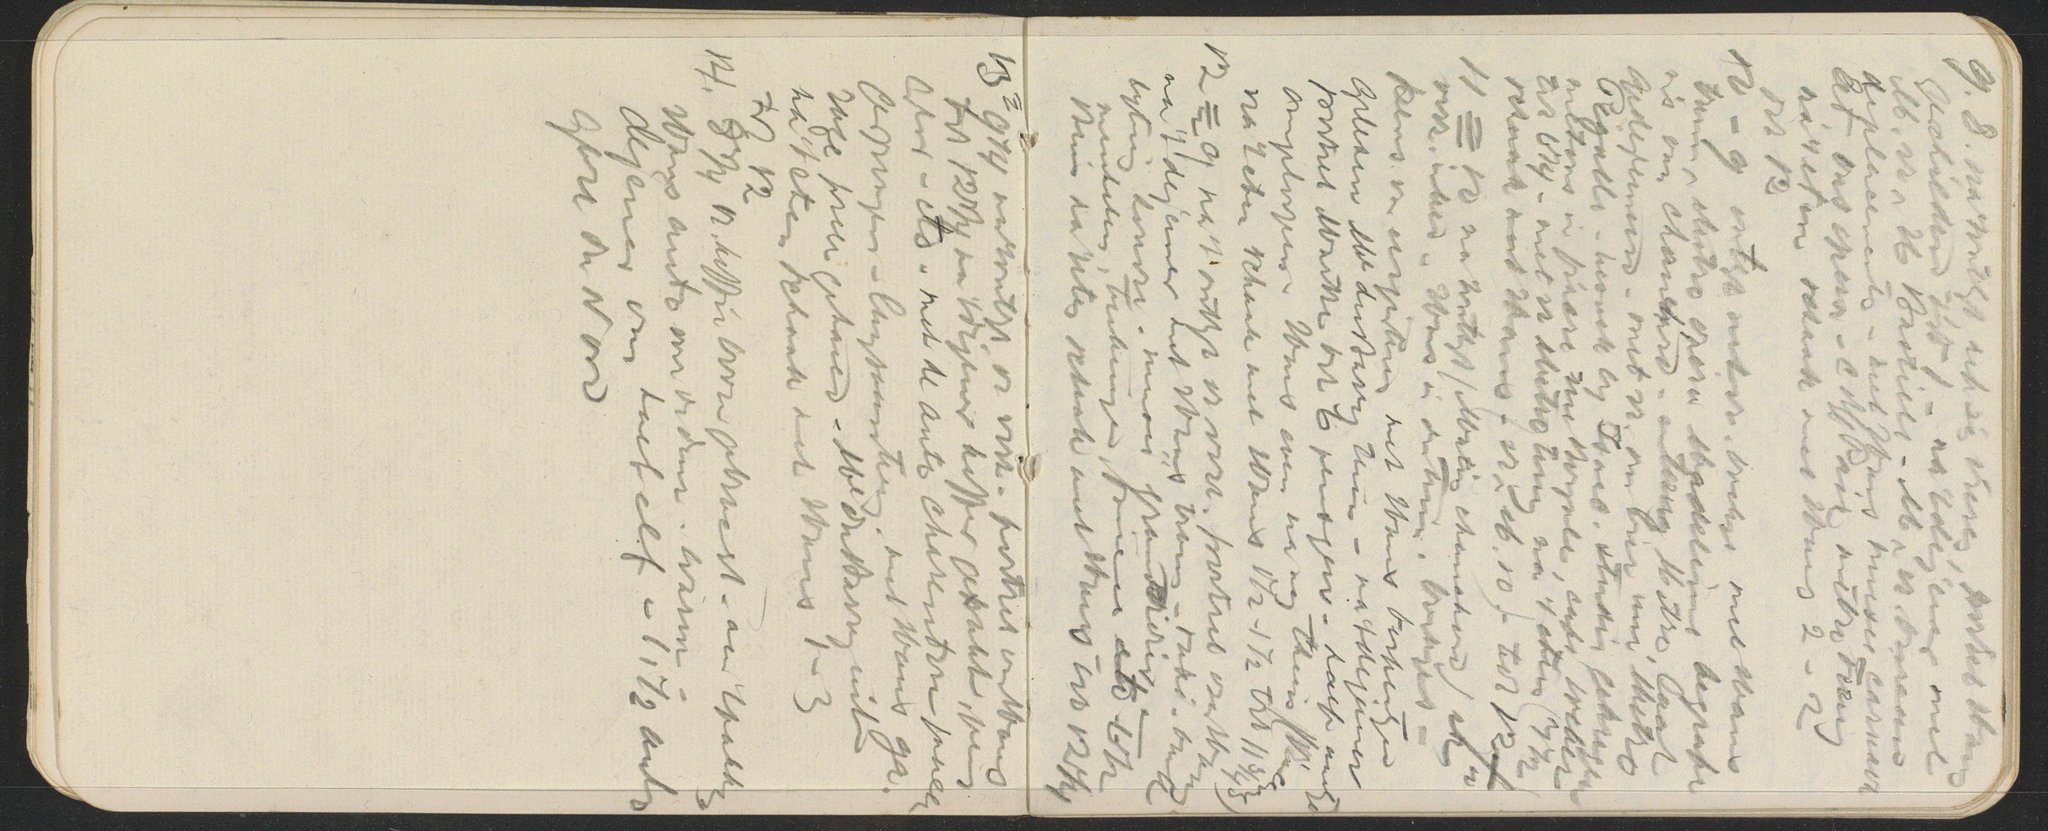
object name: sketchbook leaf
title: Dagboeknotities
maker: willem witsen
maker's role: draughtsman, painter, print maker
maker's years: 1860-1923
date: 1915-1921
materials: paper, pencil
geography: northern france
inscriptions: annotation: ‘[...]’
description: Mogelijk (deels) over de huwelijksreis van Witsen naar Noord-Frankrijk in 1893. Blad 10 verso en blad 11 recto uit een schetsboek met 23 bladen.